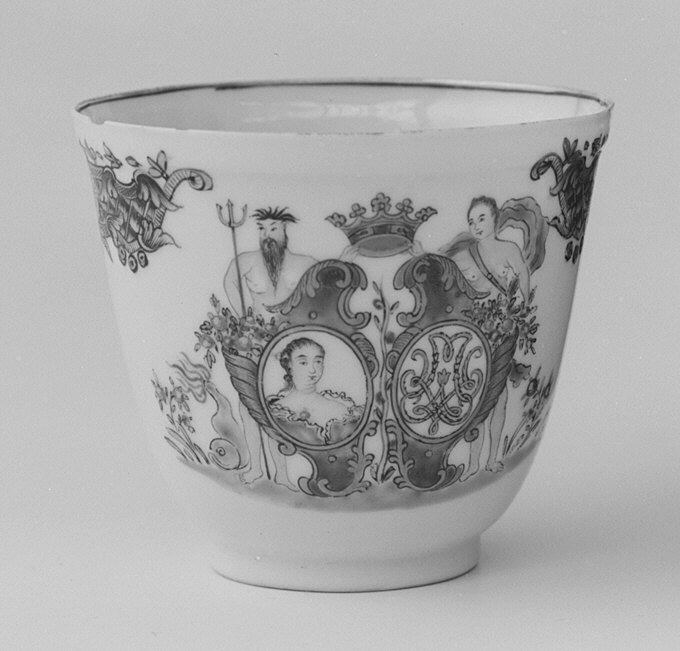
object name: cup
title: Cup (part of a set)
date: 1760-1770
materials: hard paste porcelain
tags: men,portraits,women,coat of arms